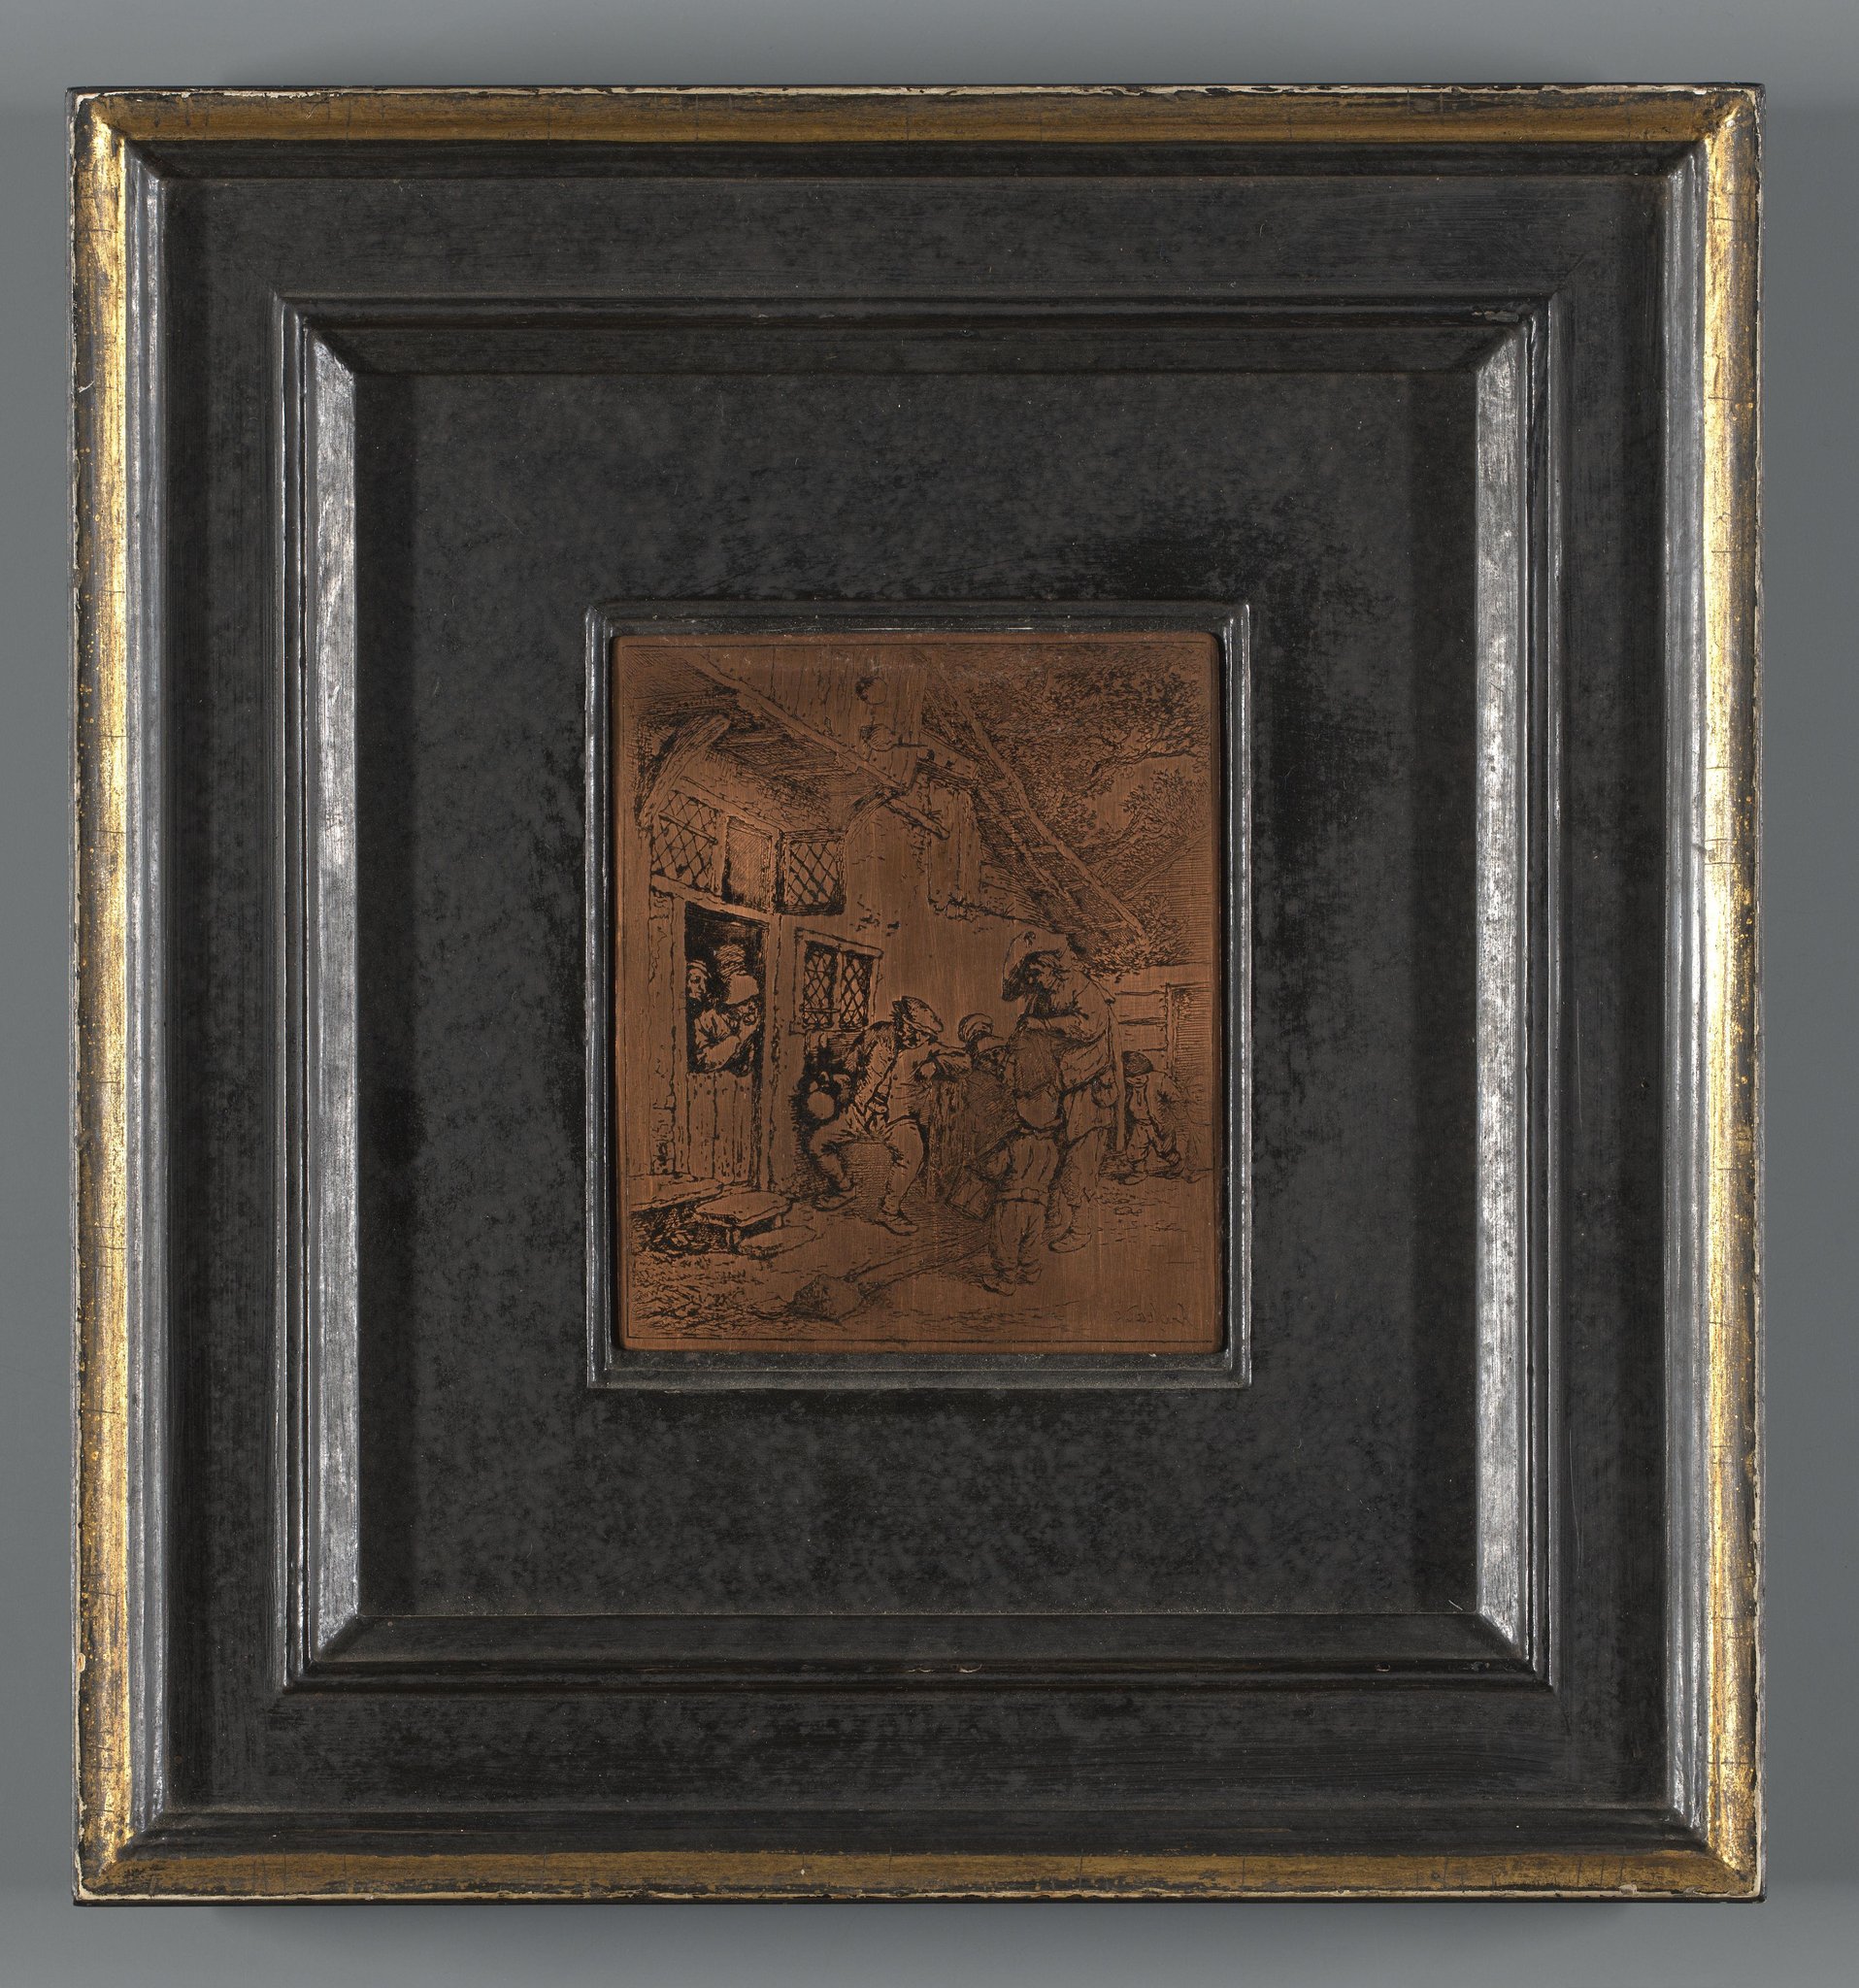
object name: copper plate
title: Rondtrekkende muzikanten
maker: adriaen van ostade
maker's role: draughtsman, painter, print maker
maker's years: 1610-1685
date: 1652-1656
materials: copper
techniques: engraving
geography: haarlem